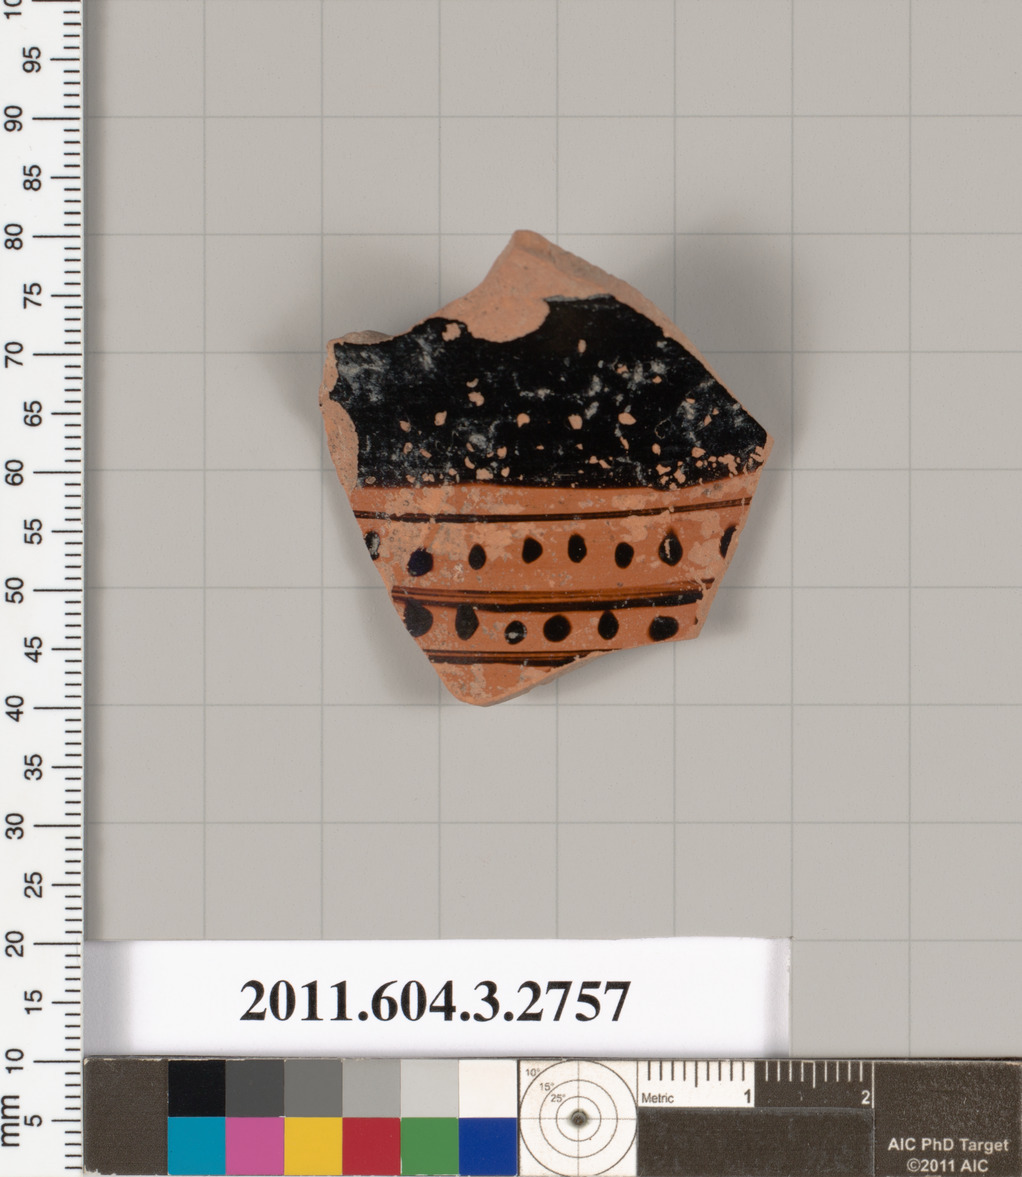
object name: chou fragment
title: Terracotta fragment of an oinochoe: chous (jug)?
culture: greek, attic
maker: class of vatican g 50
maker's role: artist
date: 534-468 BCE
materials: terracotta